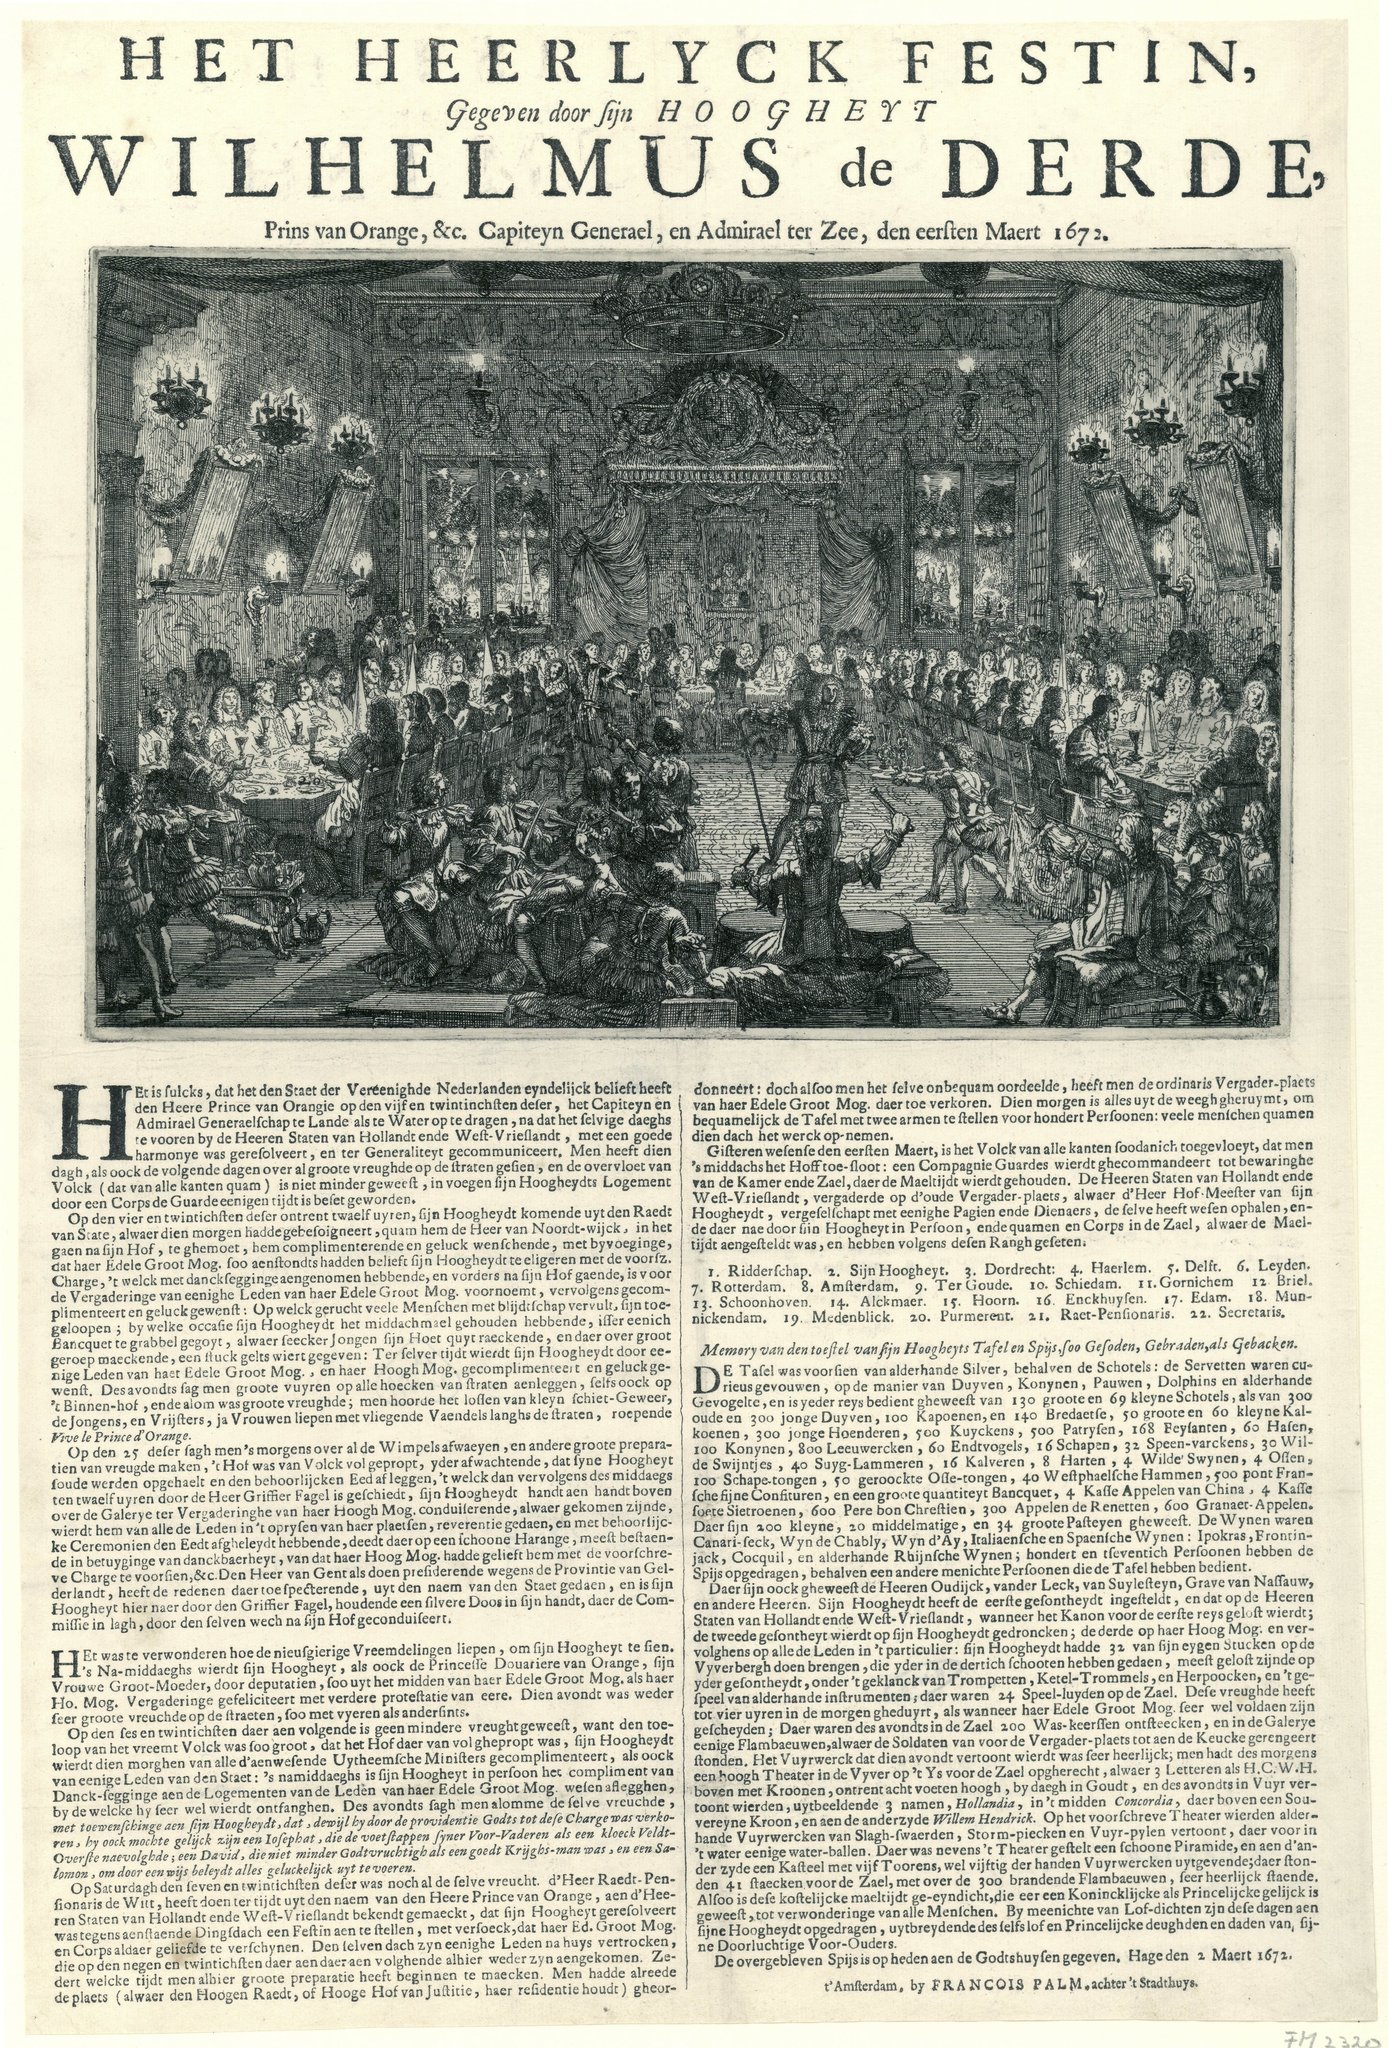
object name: print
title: Feestmaal door Willem III op 1 maart 1672 gegeven ter ere van zijn benoeming tot kapitein-generaal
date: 1672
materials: paper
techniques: etching, letterpress printing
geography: amsterdam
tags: the hague, william iii (prince of orange and king of england, scotland, and ireland), celebration meal, feast, banquet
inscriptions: date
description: Blad met een voorstelling en een beschrijving in twee kolommen van het feestmaal dat Willem III op 1 maart 1672 heeft gegeven ter ere van zijn benoeming tot kapitein-generaal. De genodigden zitten aan een lange tafel te dineren bij kaarslicht, op de voorgrond een groepje muzikanten. Onder de plaat een beschrijving in twee kolommen.